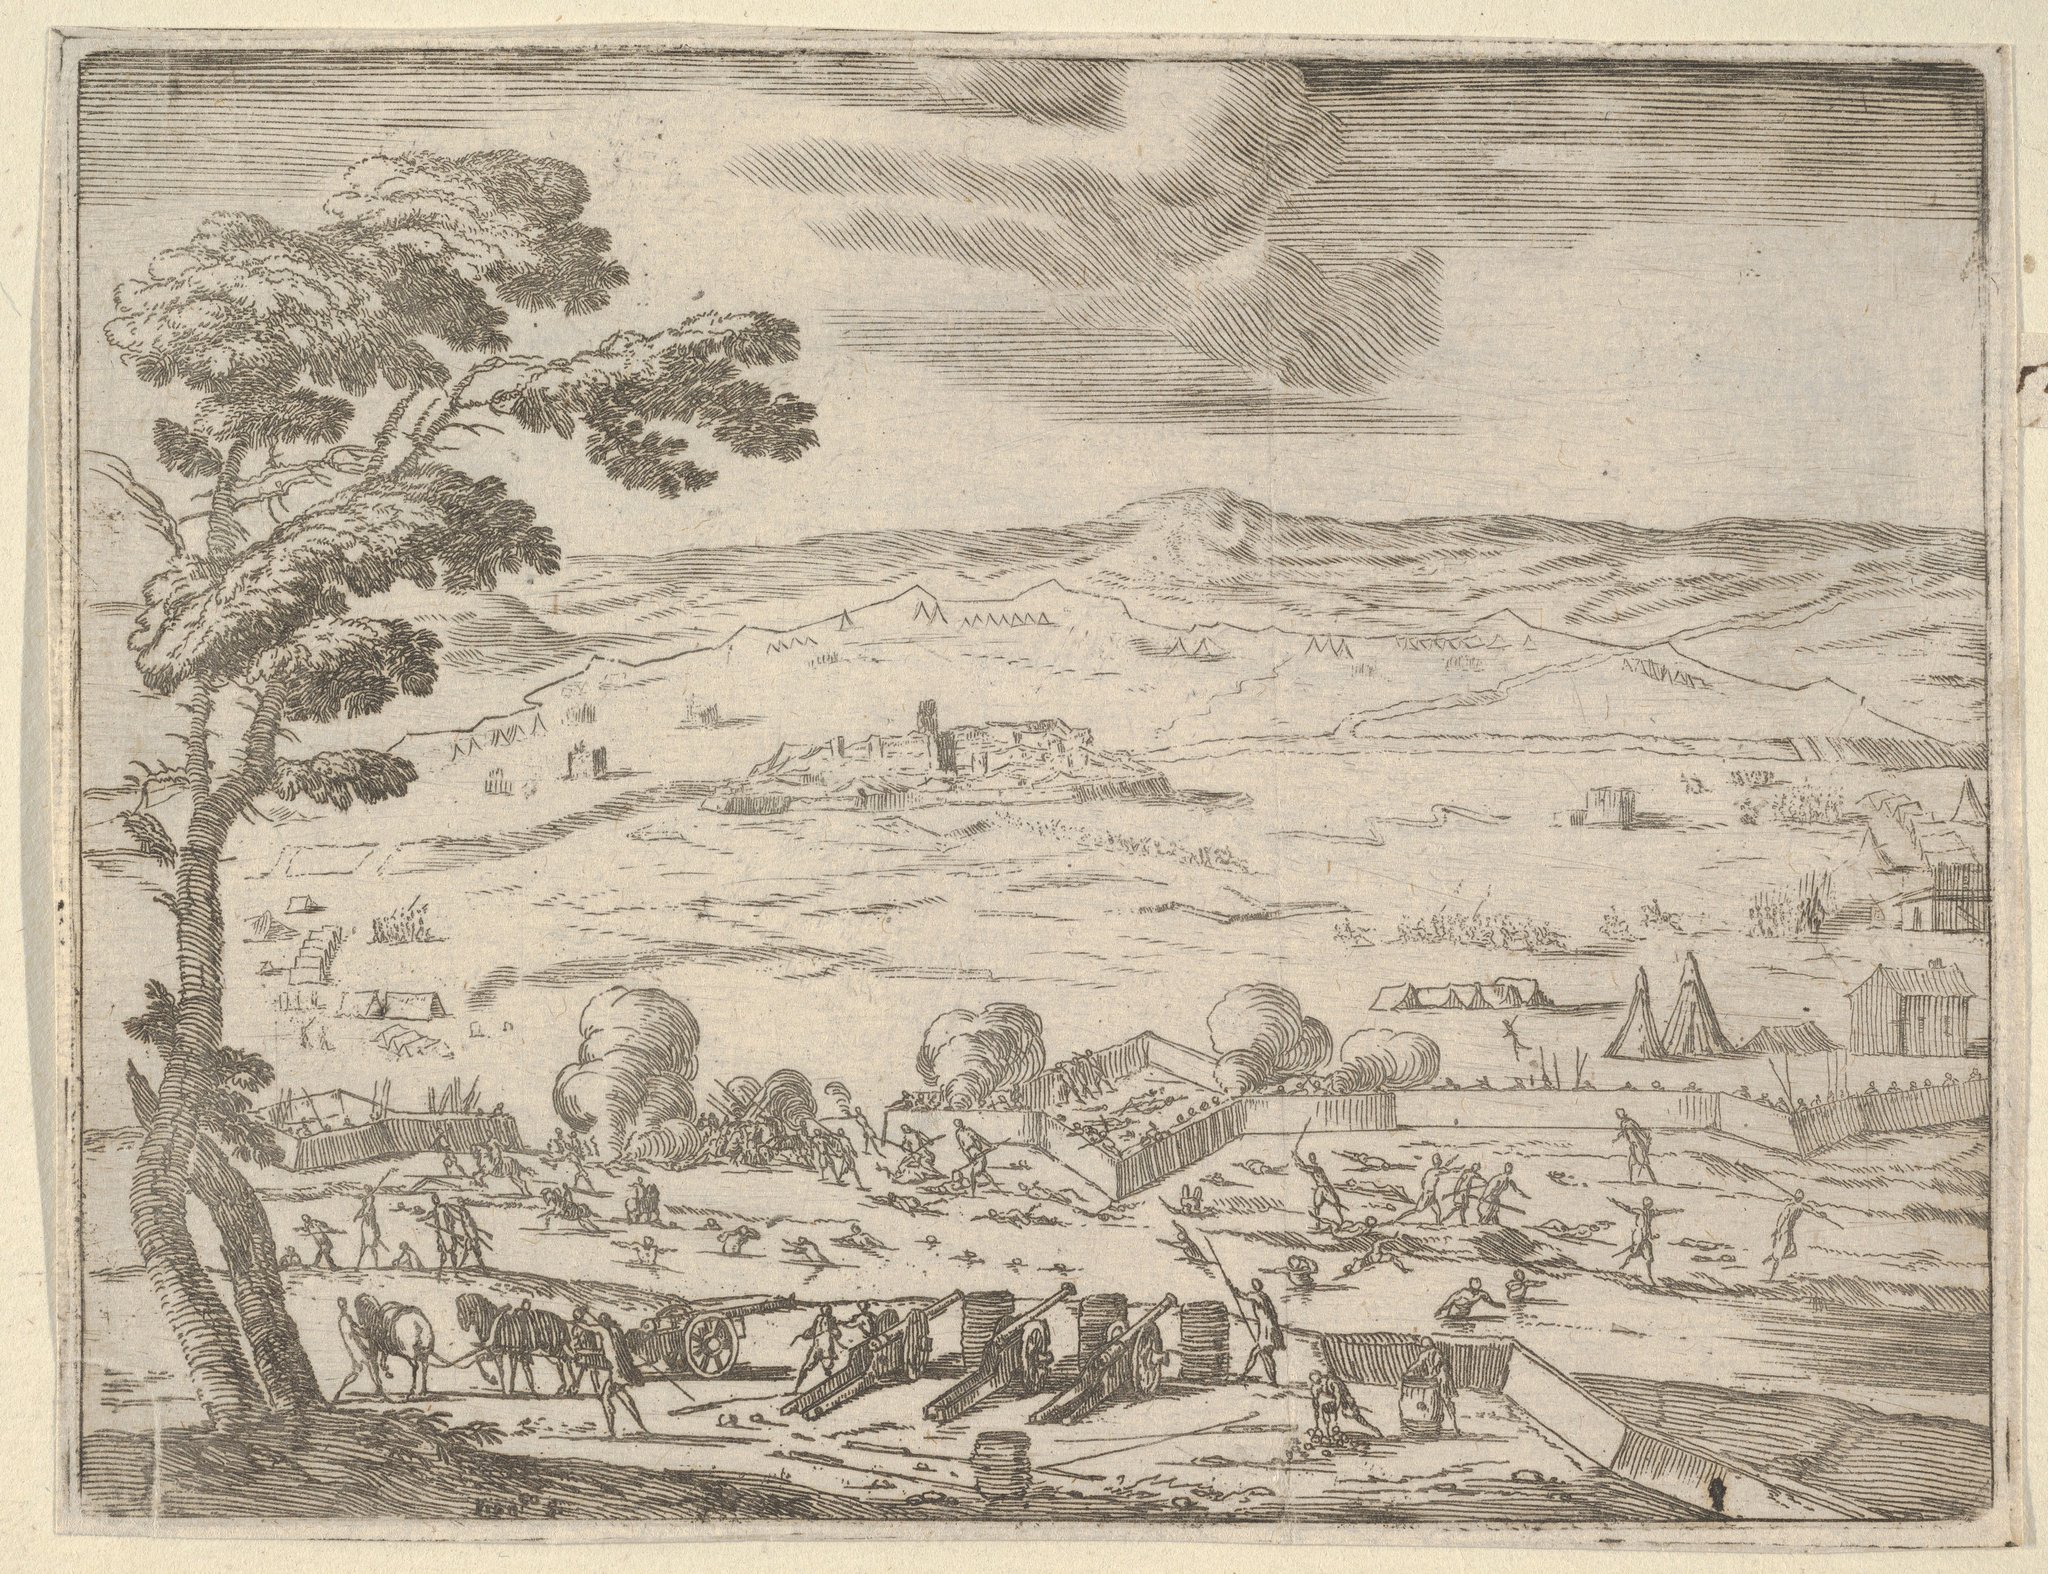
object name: print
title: German and Spanish Forts Near Bohemia Were Taken with Great Force Near Bohemia, from "L'Idea di un Principe ed Eroe Cristiano in Francesco I d'Este, di Modena e Reggio Duca VIII [...]"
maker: bartolomeo fenice (fénis)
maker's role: artist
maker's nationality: italian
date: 1659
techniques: etching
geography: italy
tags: wars,soldiers,cannons,trees